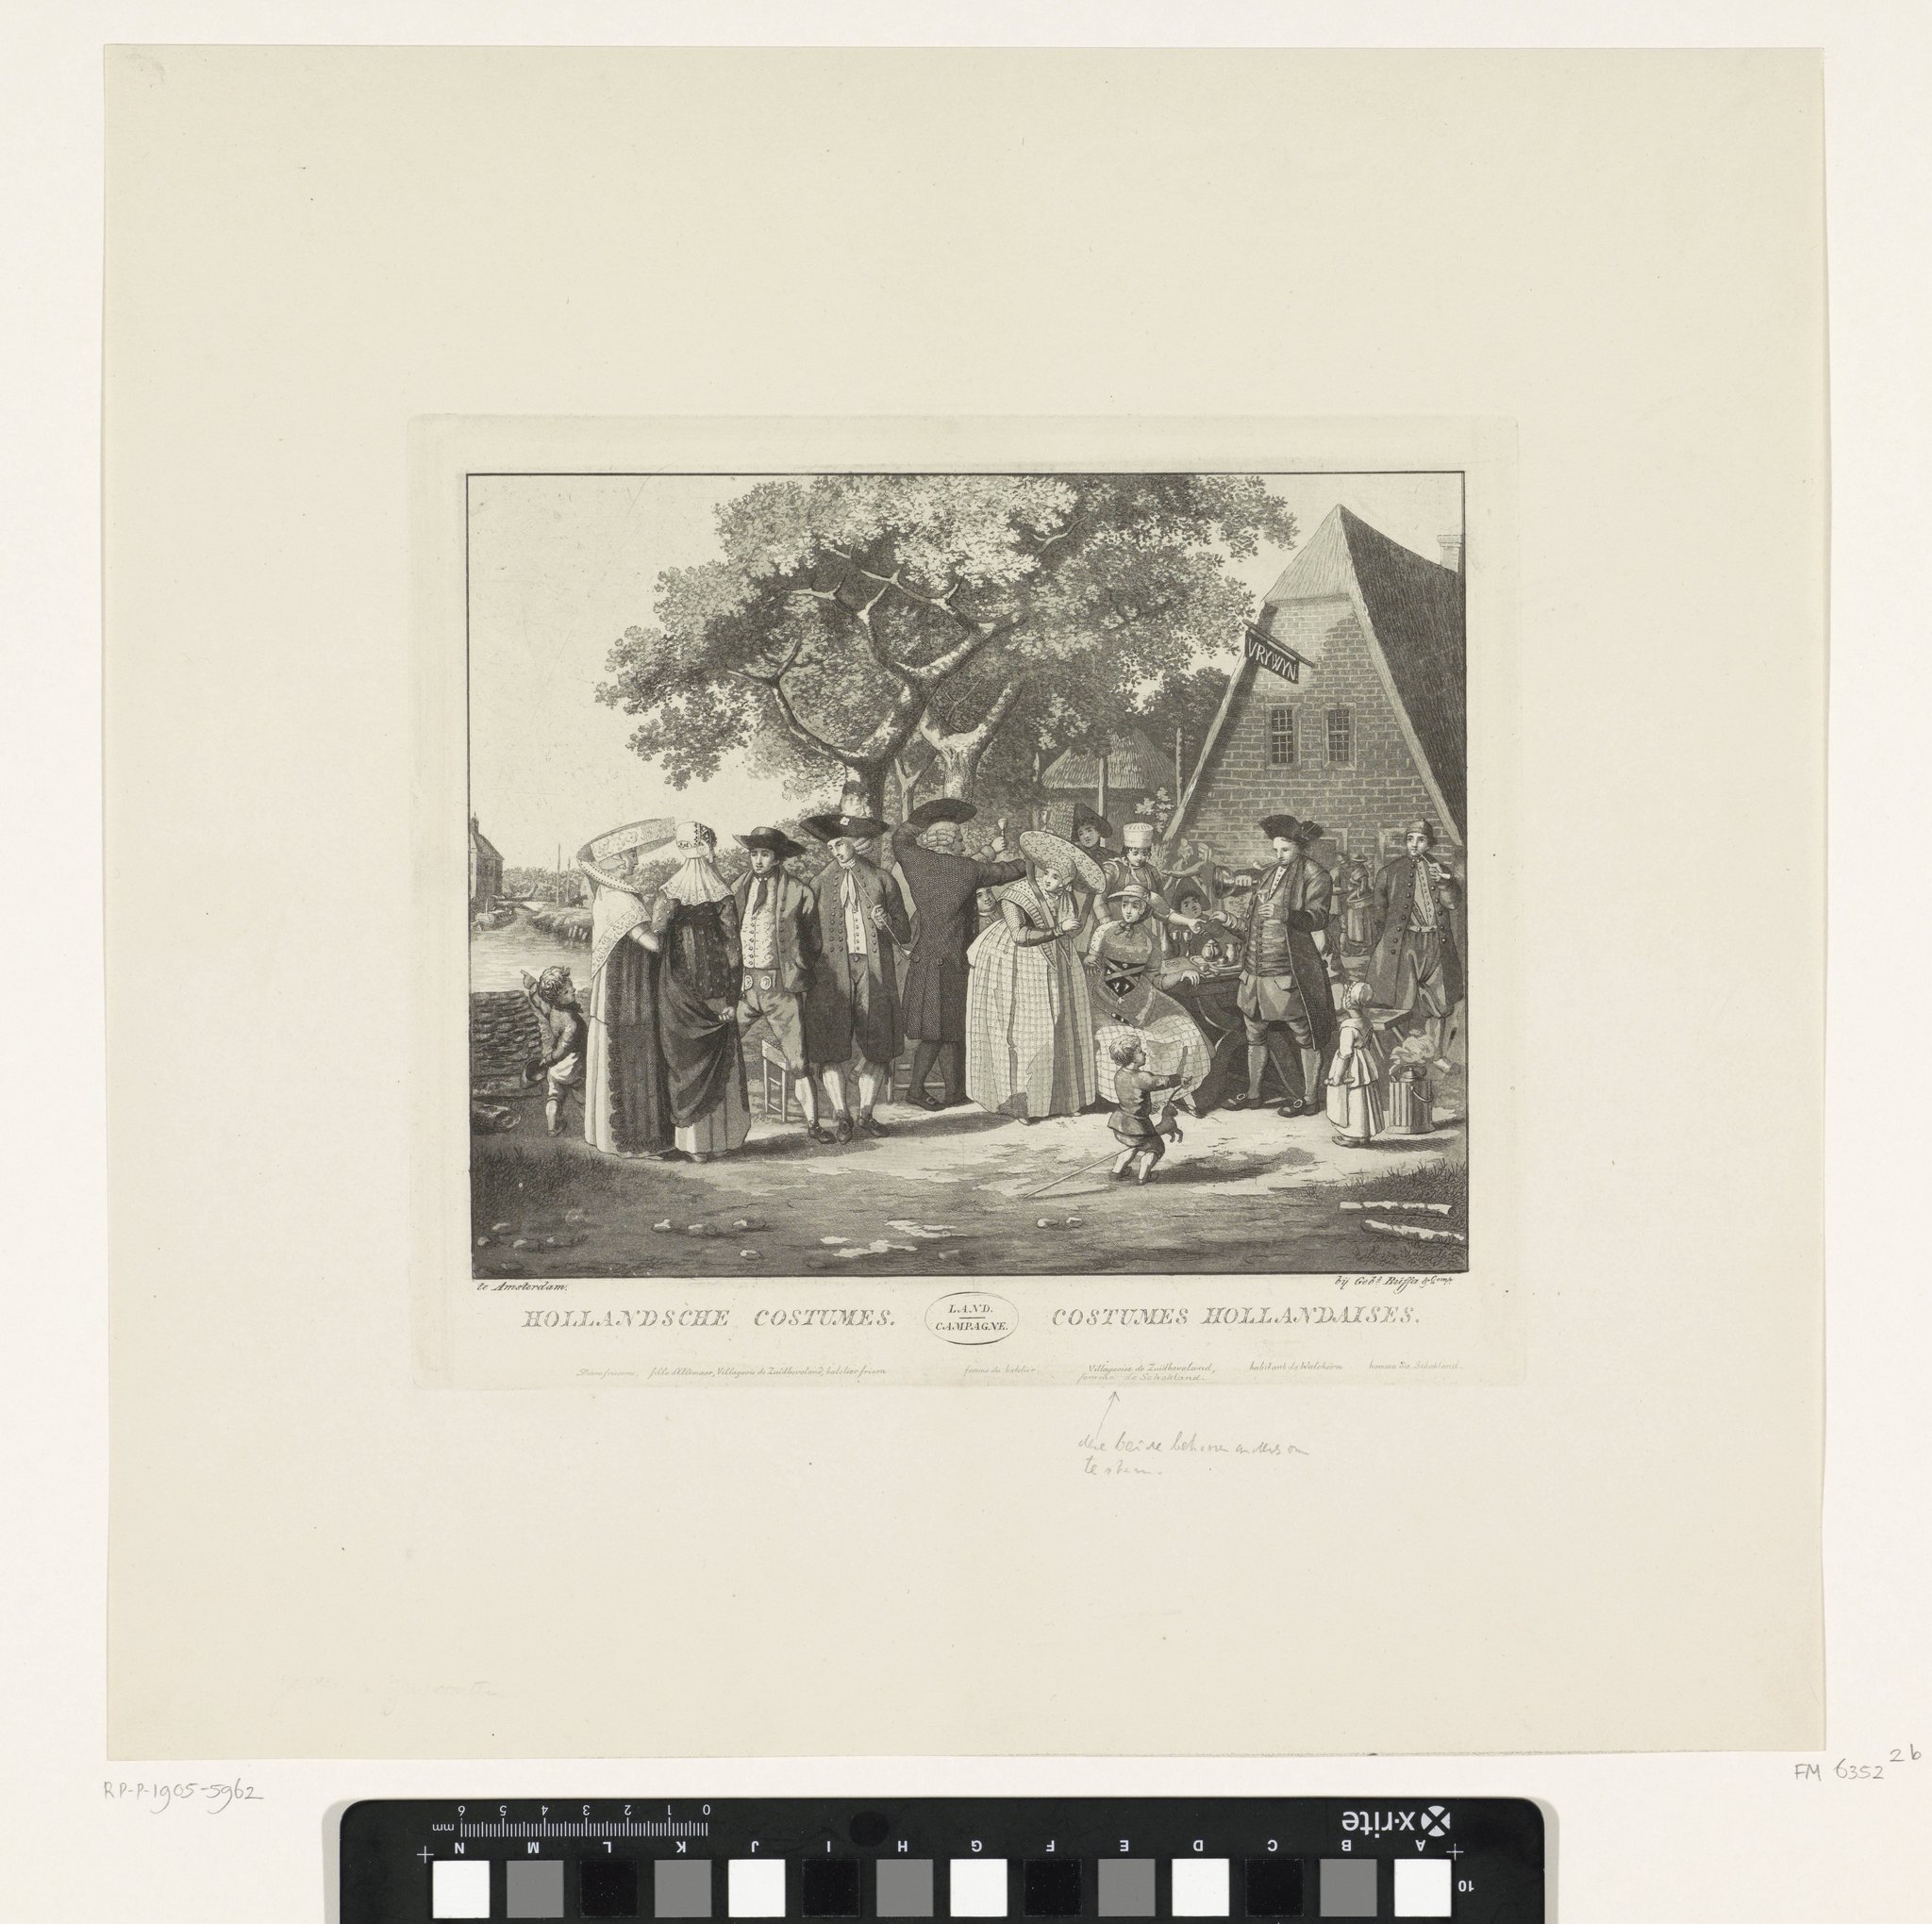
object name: print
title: Twaalf personen in klederdracht van verschillende streken, ca. 1820-1830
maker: ludwig gottlieb portman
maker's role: print maker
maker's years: 1772-1828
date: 1820-1830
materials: paper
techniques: aquatint, etching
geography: amsterdam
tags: professional clothes, inn, coffee-house, public house, etc., folk costume, regional costume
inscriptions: collector's mark: Lugt 2228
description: Twaalf personen in klederdracht van verschillende landstreken, verzameld voor een dorpsherberg, ca. 1820-1830. Volgens de opschriften onder de titel gaat het om personen uit de streken Friesland, Alkmaar, Zuid-Beveland, Schokland en Walcheren. Zie ook de pendant.